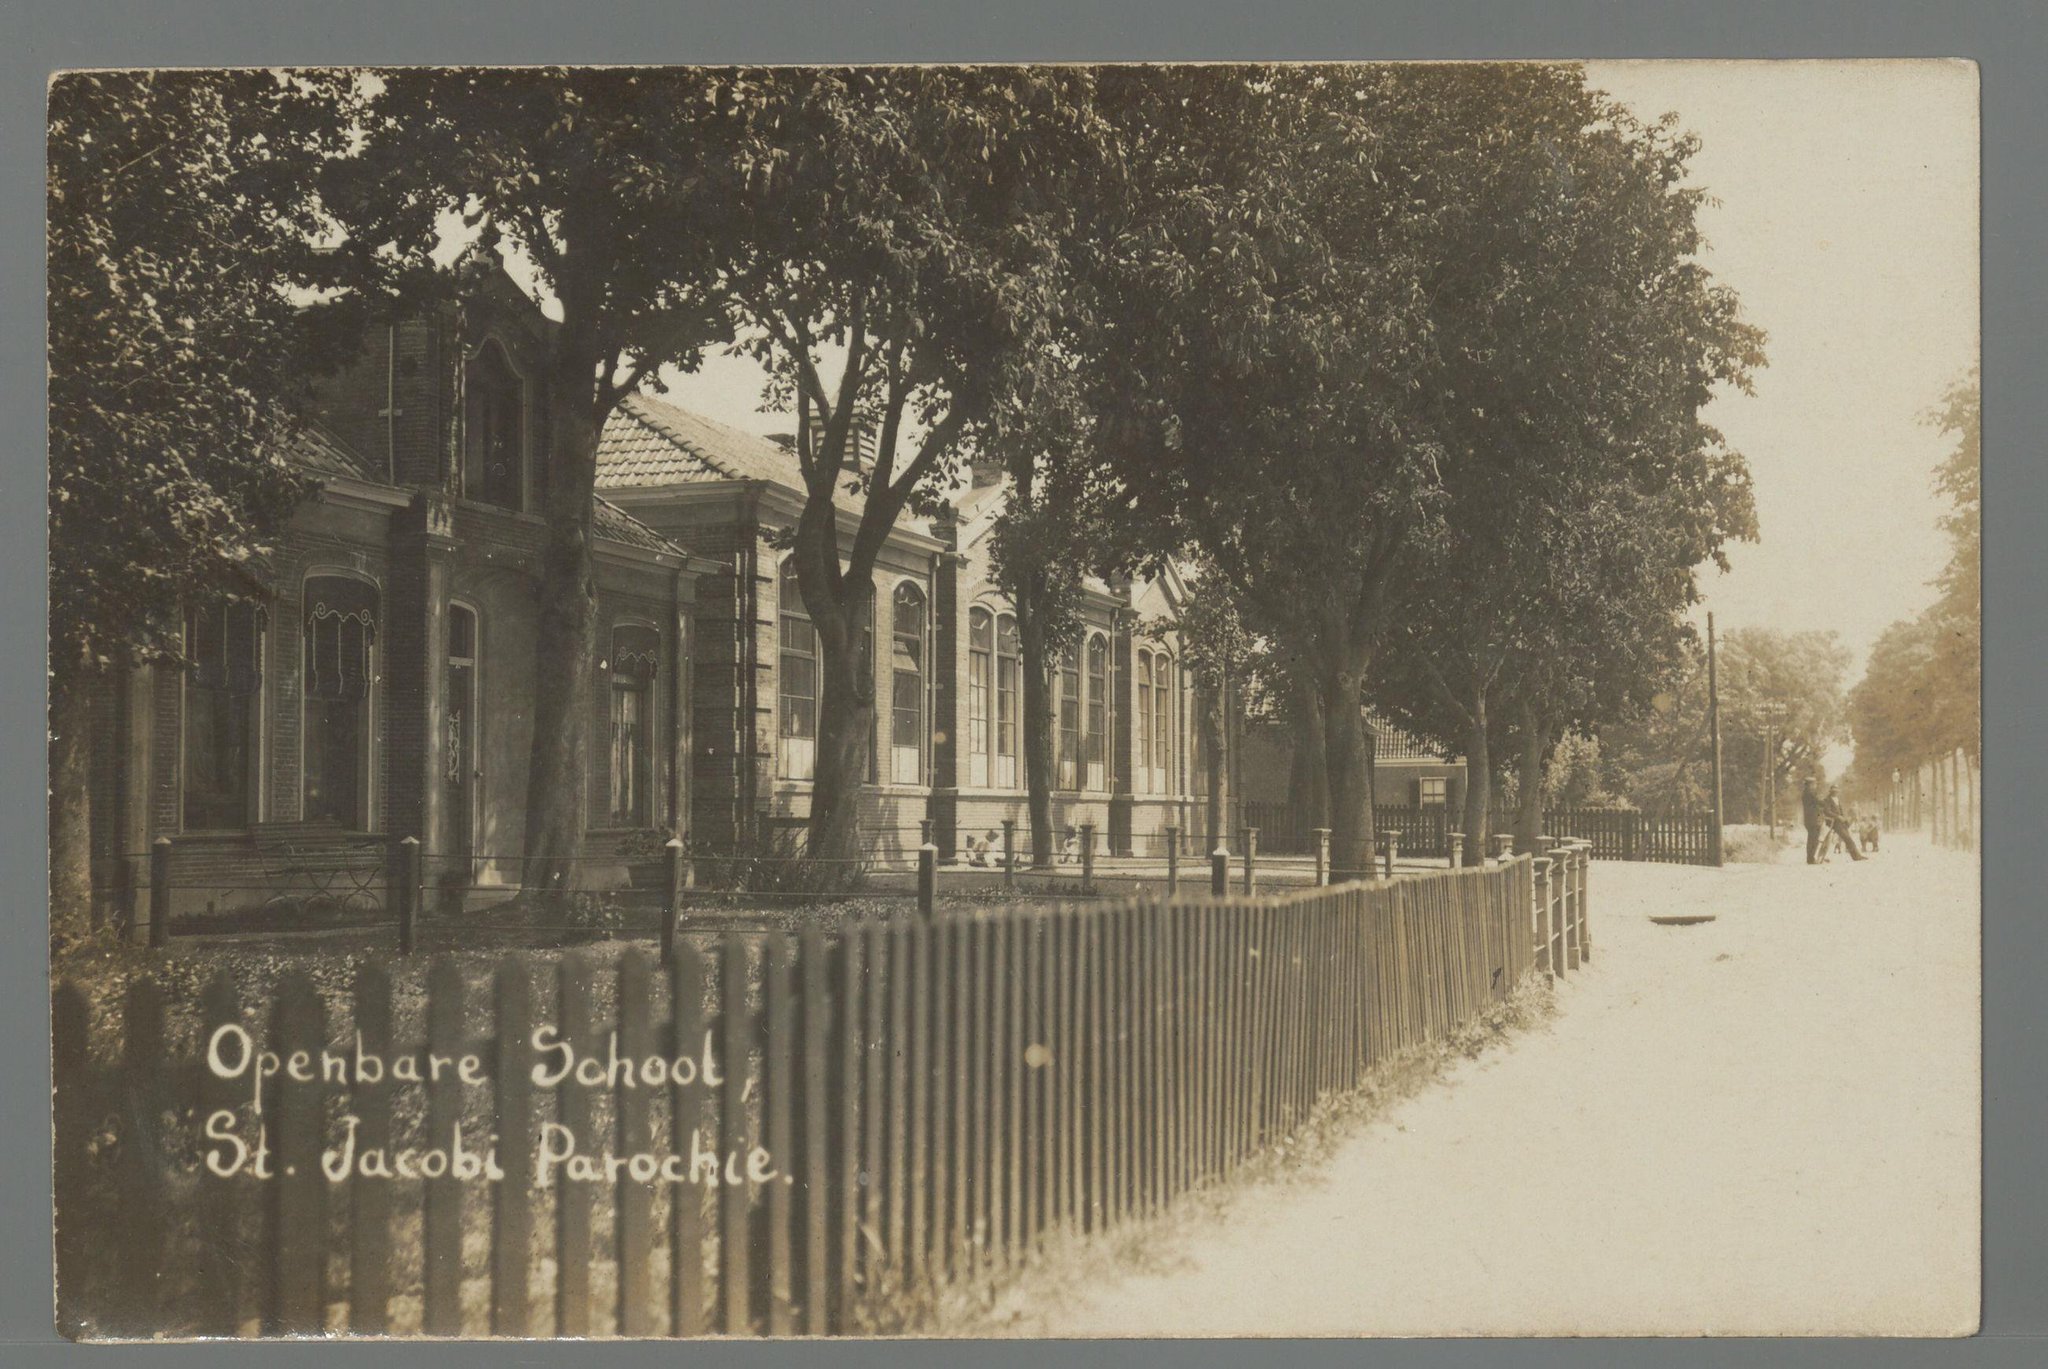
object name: ansichtkaart, prentbriefkaart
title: Openbare School, St. Jacobi Parochie.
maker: Anonymous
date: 1905-1919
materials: photographic support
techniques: photography, writing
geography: sint jacobiparochie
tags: city-view, and landscape with man-made constructions, further education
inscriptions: poststempel, verso, gestempeld